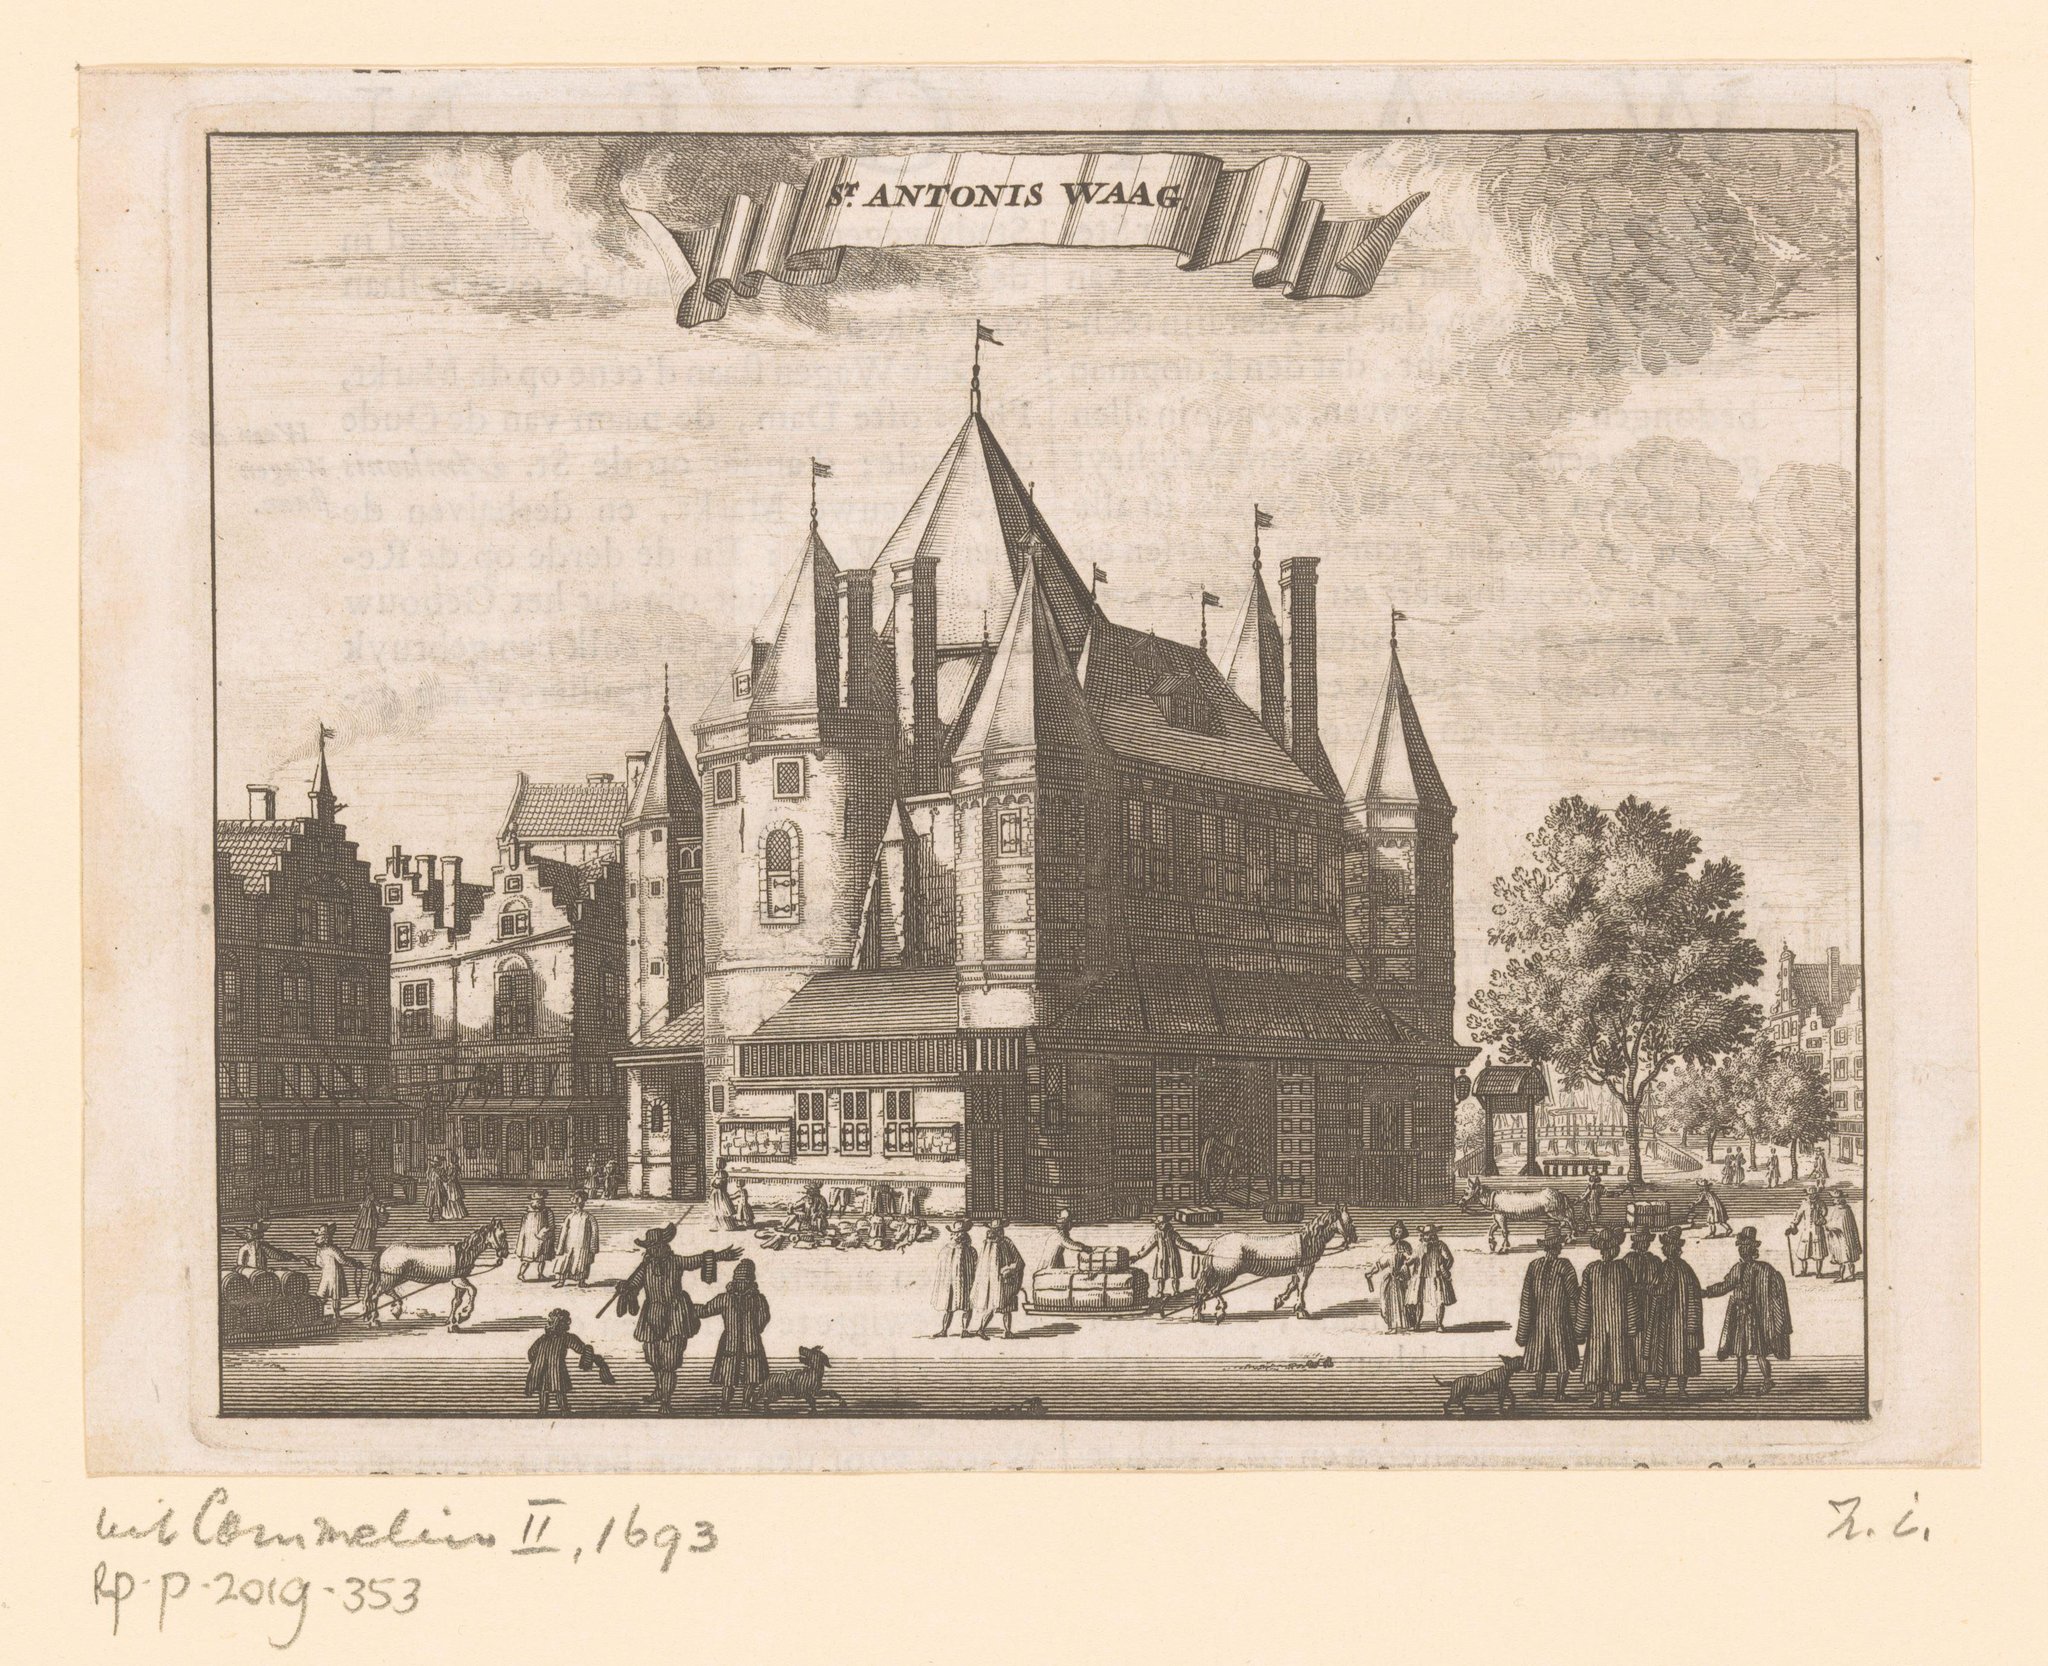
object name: book illustration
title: Gezicht op de Waag op de Nieuwmarkt in Amsterdam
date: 1694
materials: paper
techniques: engraving, etching, letterpress printing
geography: amsterdam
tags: weigh-house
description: rent uit: Commelin, Caspar. Beschryvinge van Amsterdam (...). 2 dln. Amsterdam: Abraham Wolfgang et al., 1693, dl. 2, p. 630. En in latere edities van dit werk (Amsterdam: Weduwe Aart Dircksz. Oossaan, 1694 en Amsterdam: Andries van Damme et al., 1726).